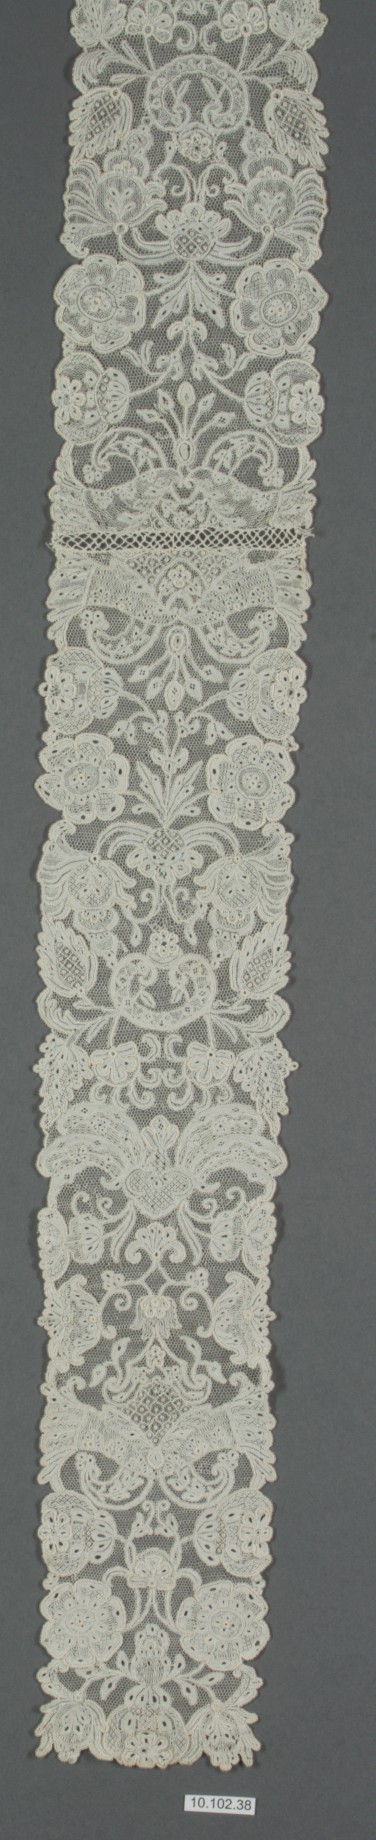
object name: barbe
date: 1701-1800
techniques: lace